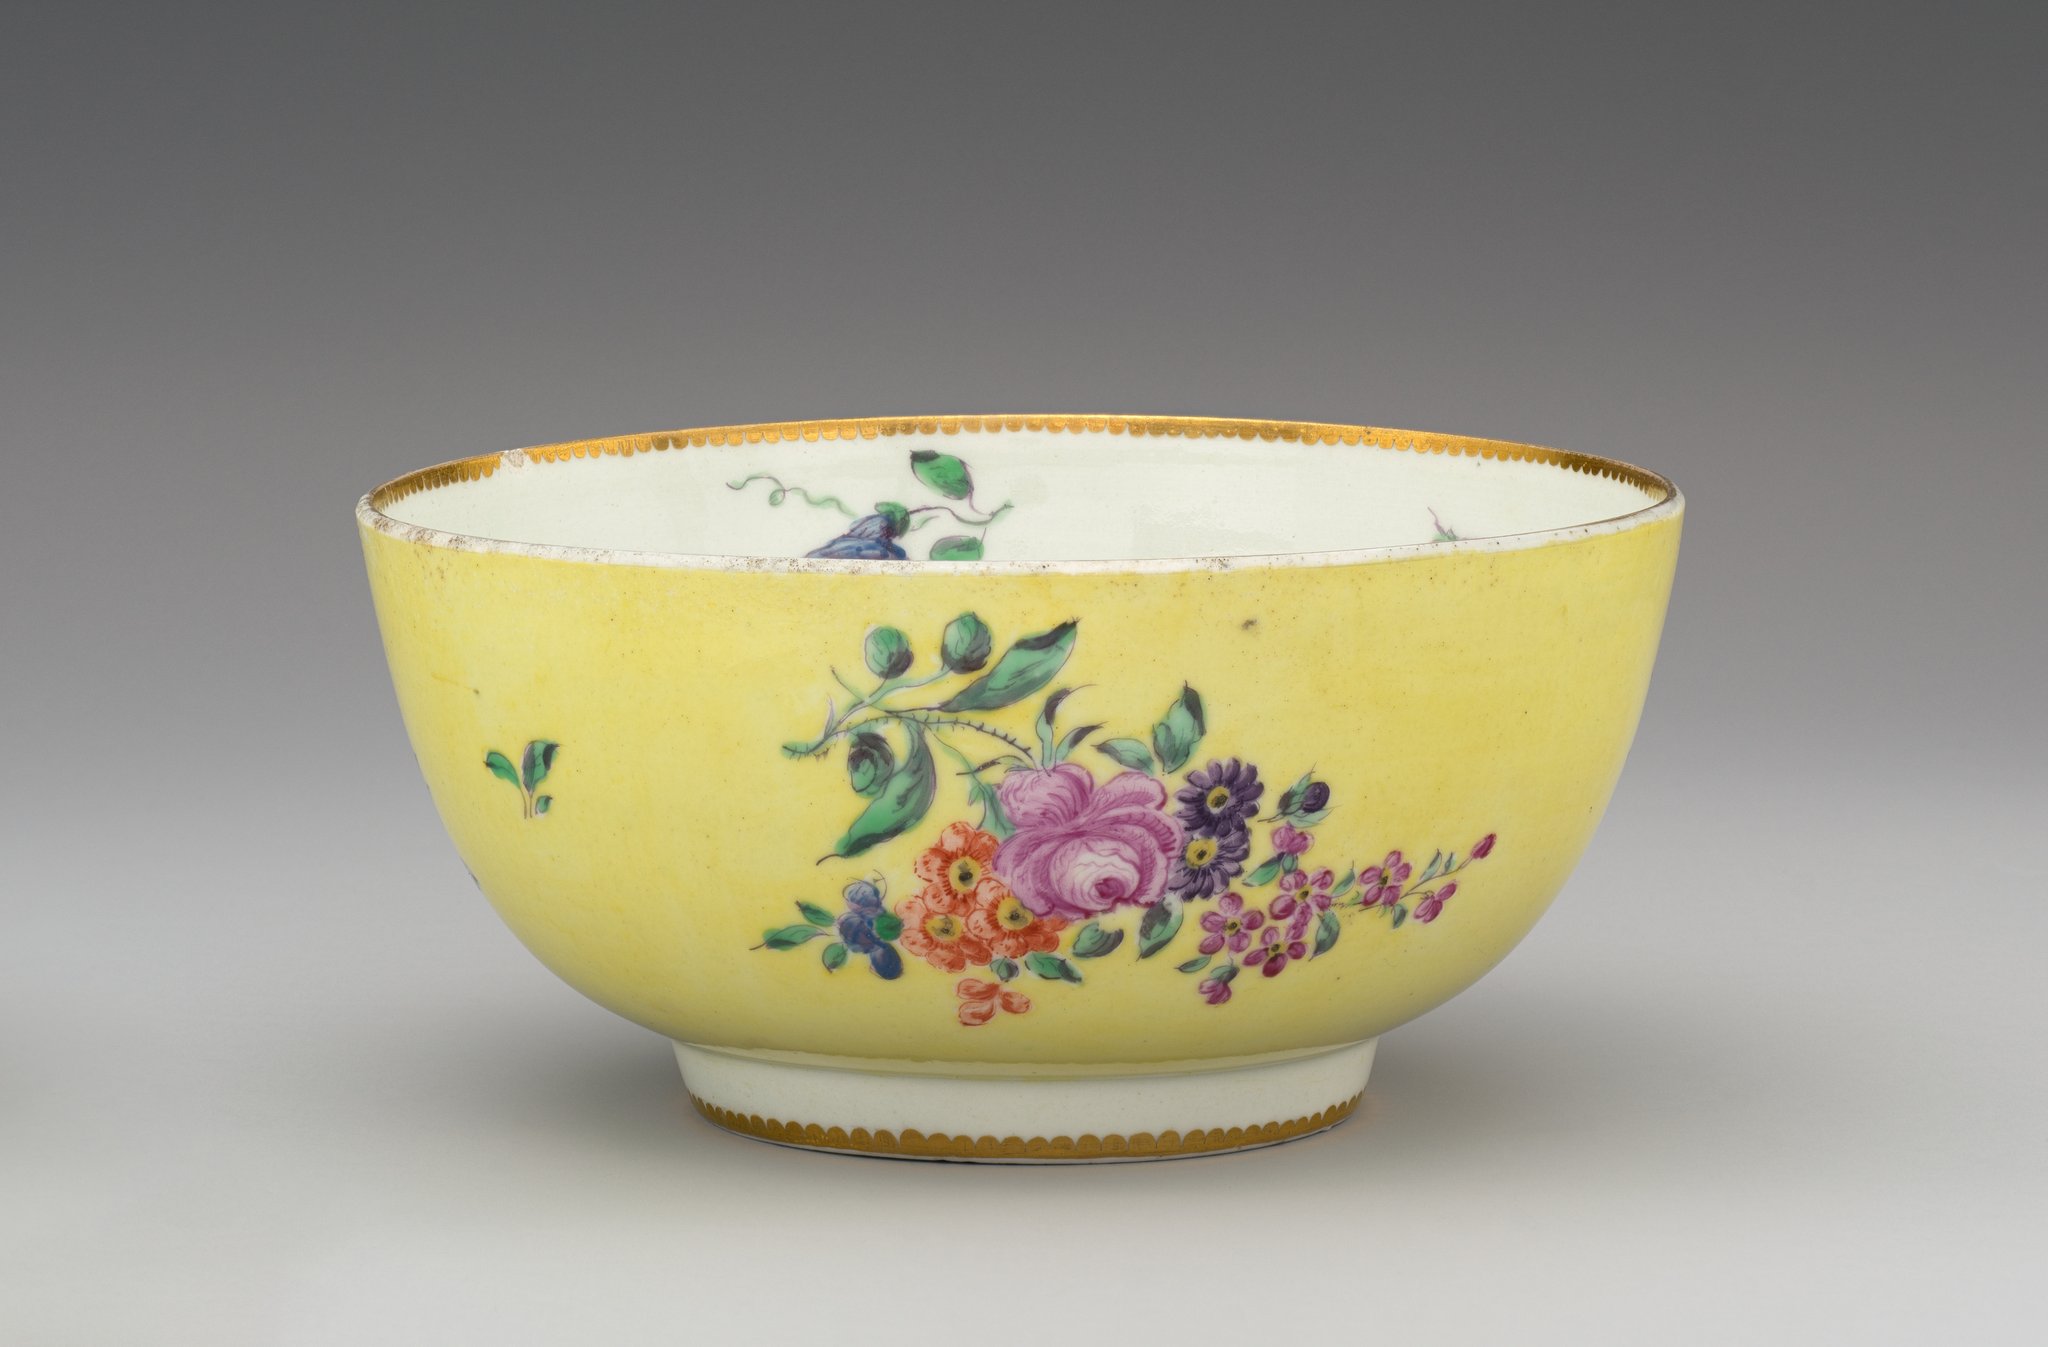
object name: bowl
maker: worcester factory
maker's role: factory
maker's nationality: british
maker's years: 1751-2008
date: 1770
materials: soft paste porcelain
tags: flowers